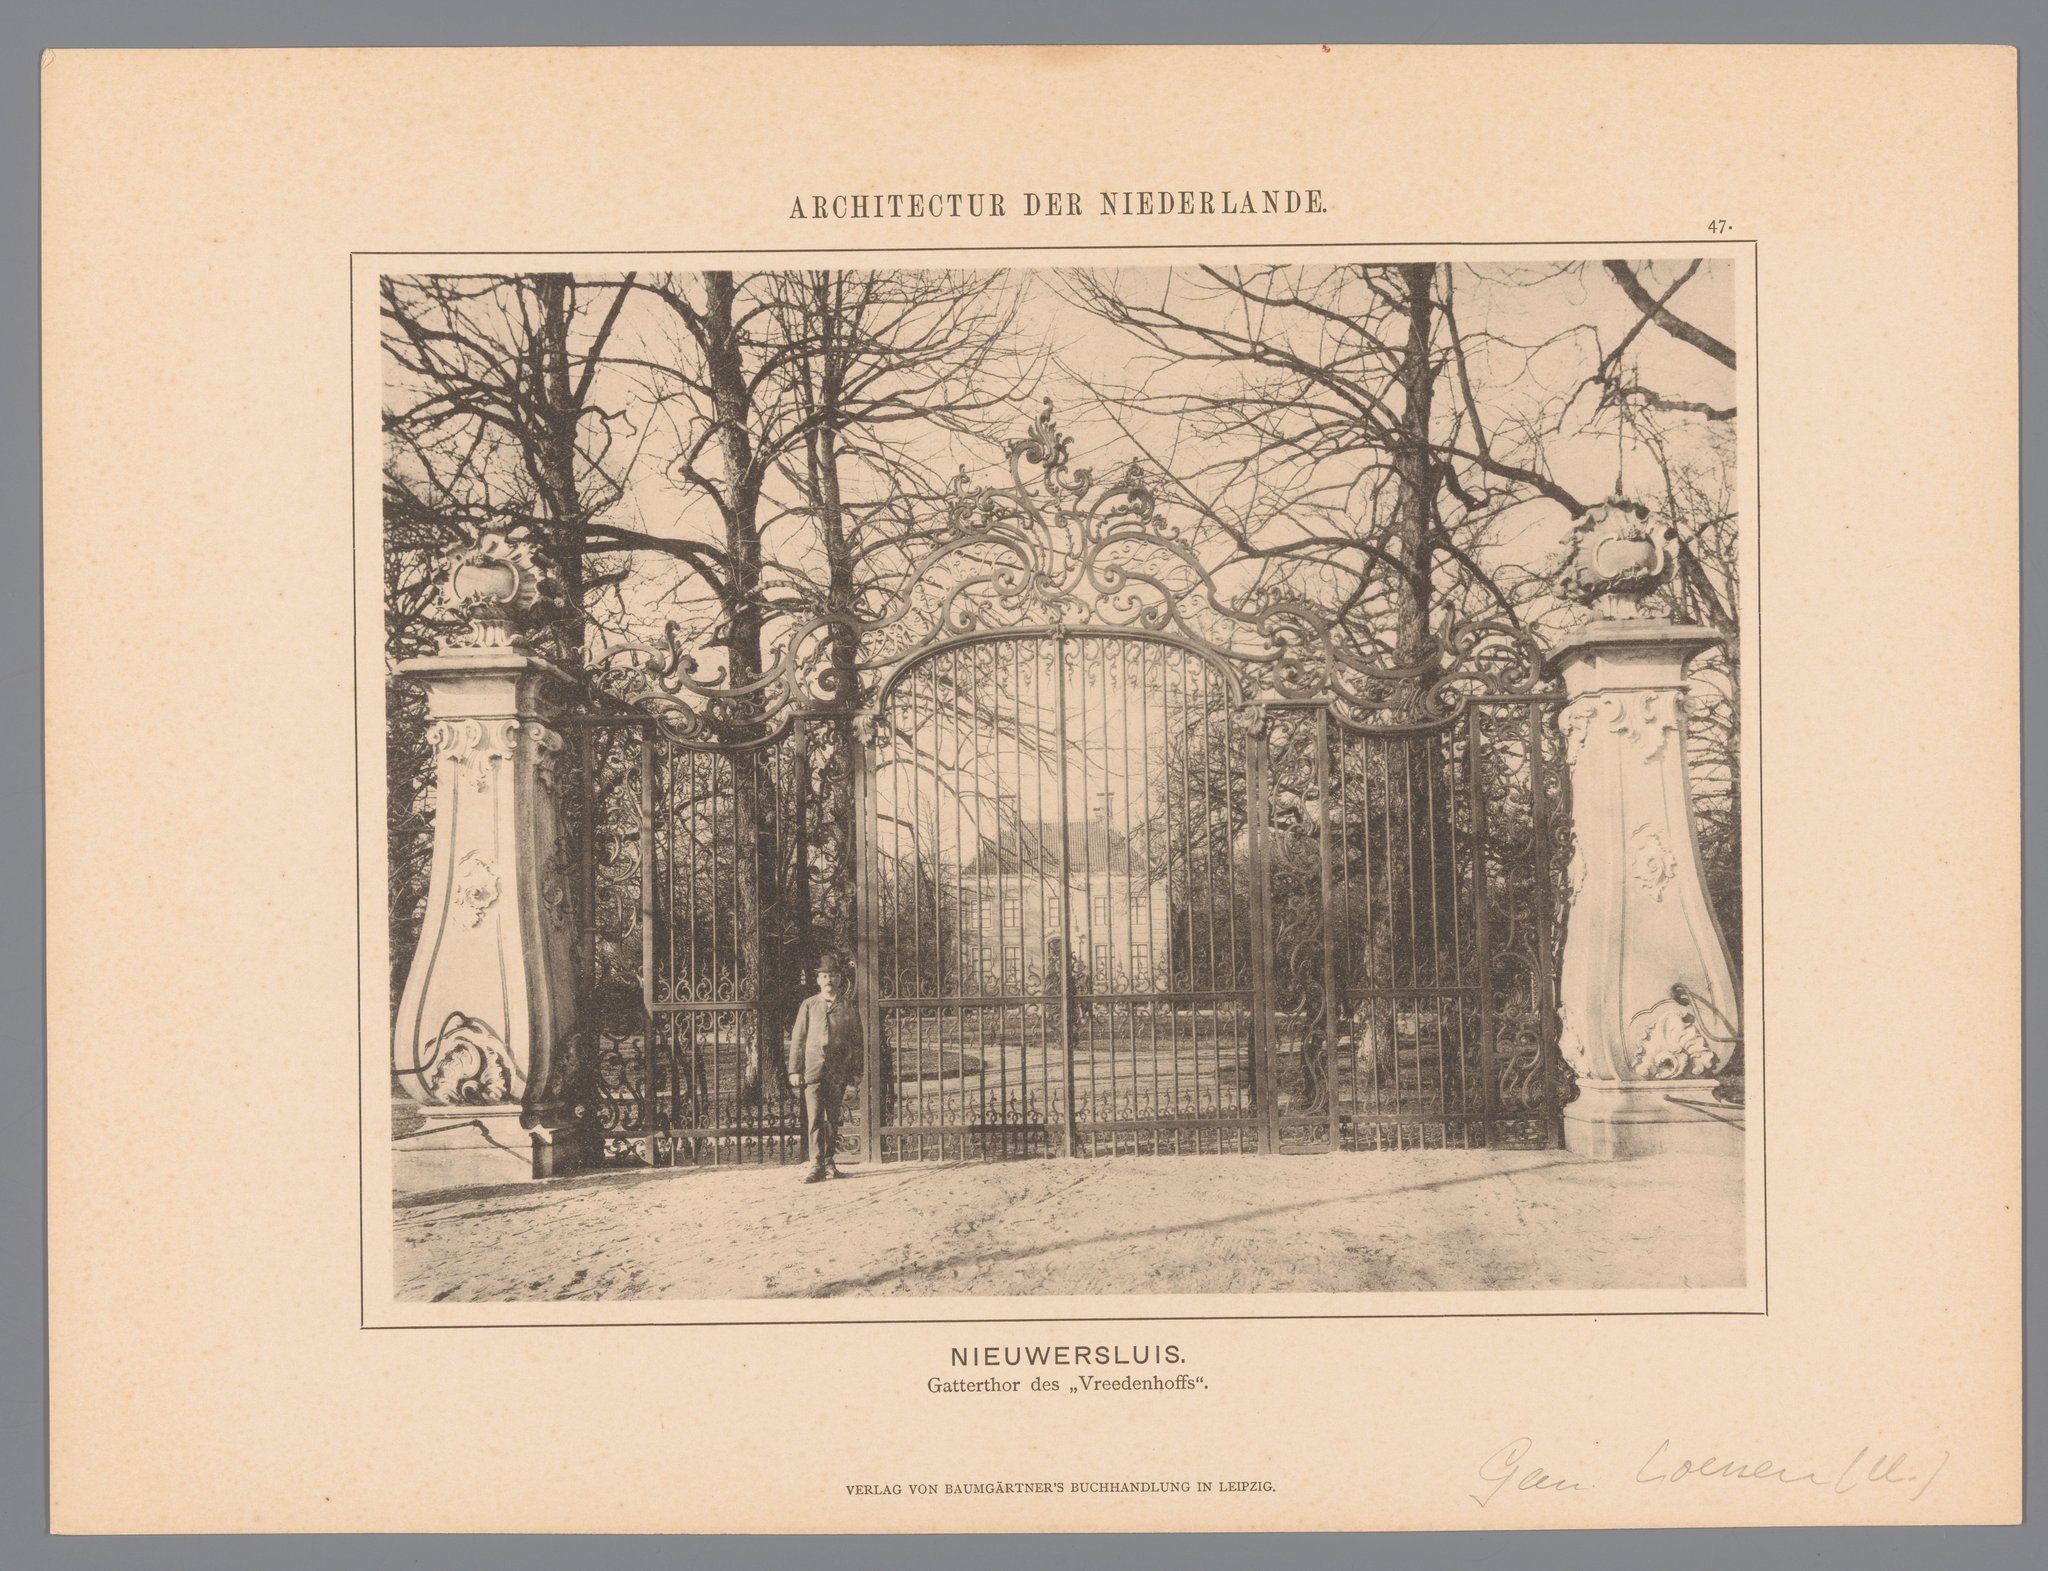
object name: photomechanical print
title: Gezicht op de buitenplaats Vreedenhoff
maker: Anonymous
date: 1894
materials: paper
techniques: photograph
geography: leipzig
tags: rural housing, e.g. country-house, villa, cottage, gate, entrance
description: Afdruk uit: Krook, L. Architectur der Niederlande. Leipzig: Baumgärtner's Buchhandlung, 1894.